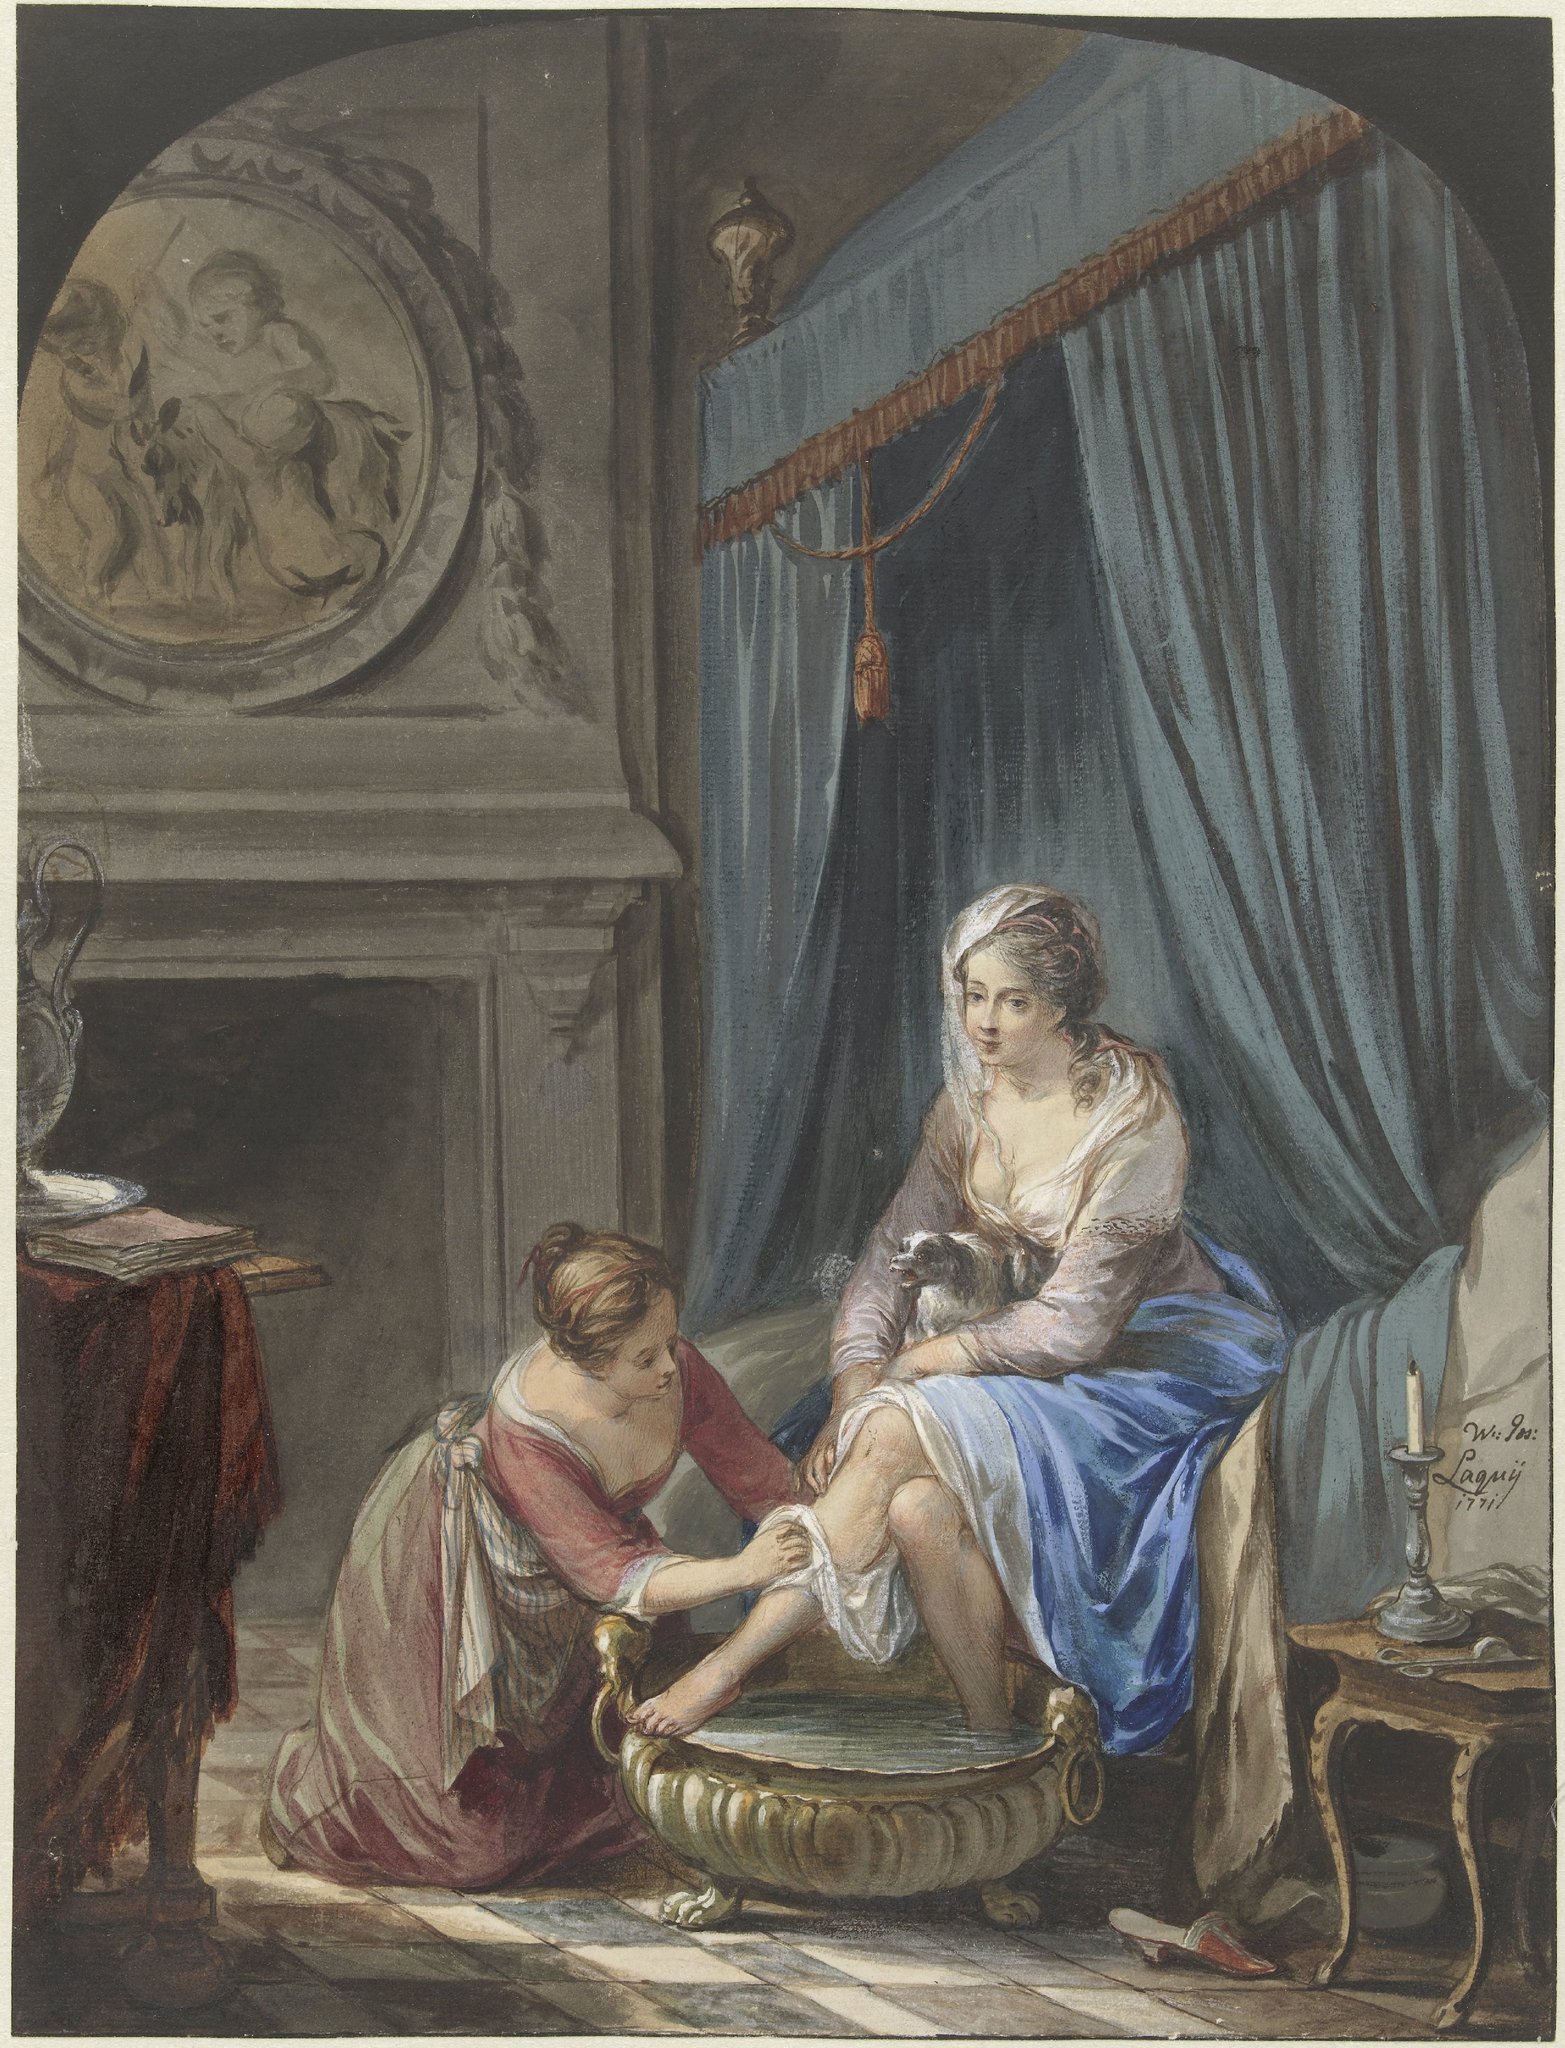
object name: watercolor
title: Toilet van een jonge vrouw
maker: willem joseph laquy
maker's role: draughtsman, painter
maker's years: 1738-1798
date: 1771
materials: ink, paper, watercolor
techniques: brush, pen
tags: washing another person's feet, bedroom